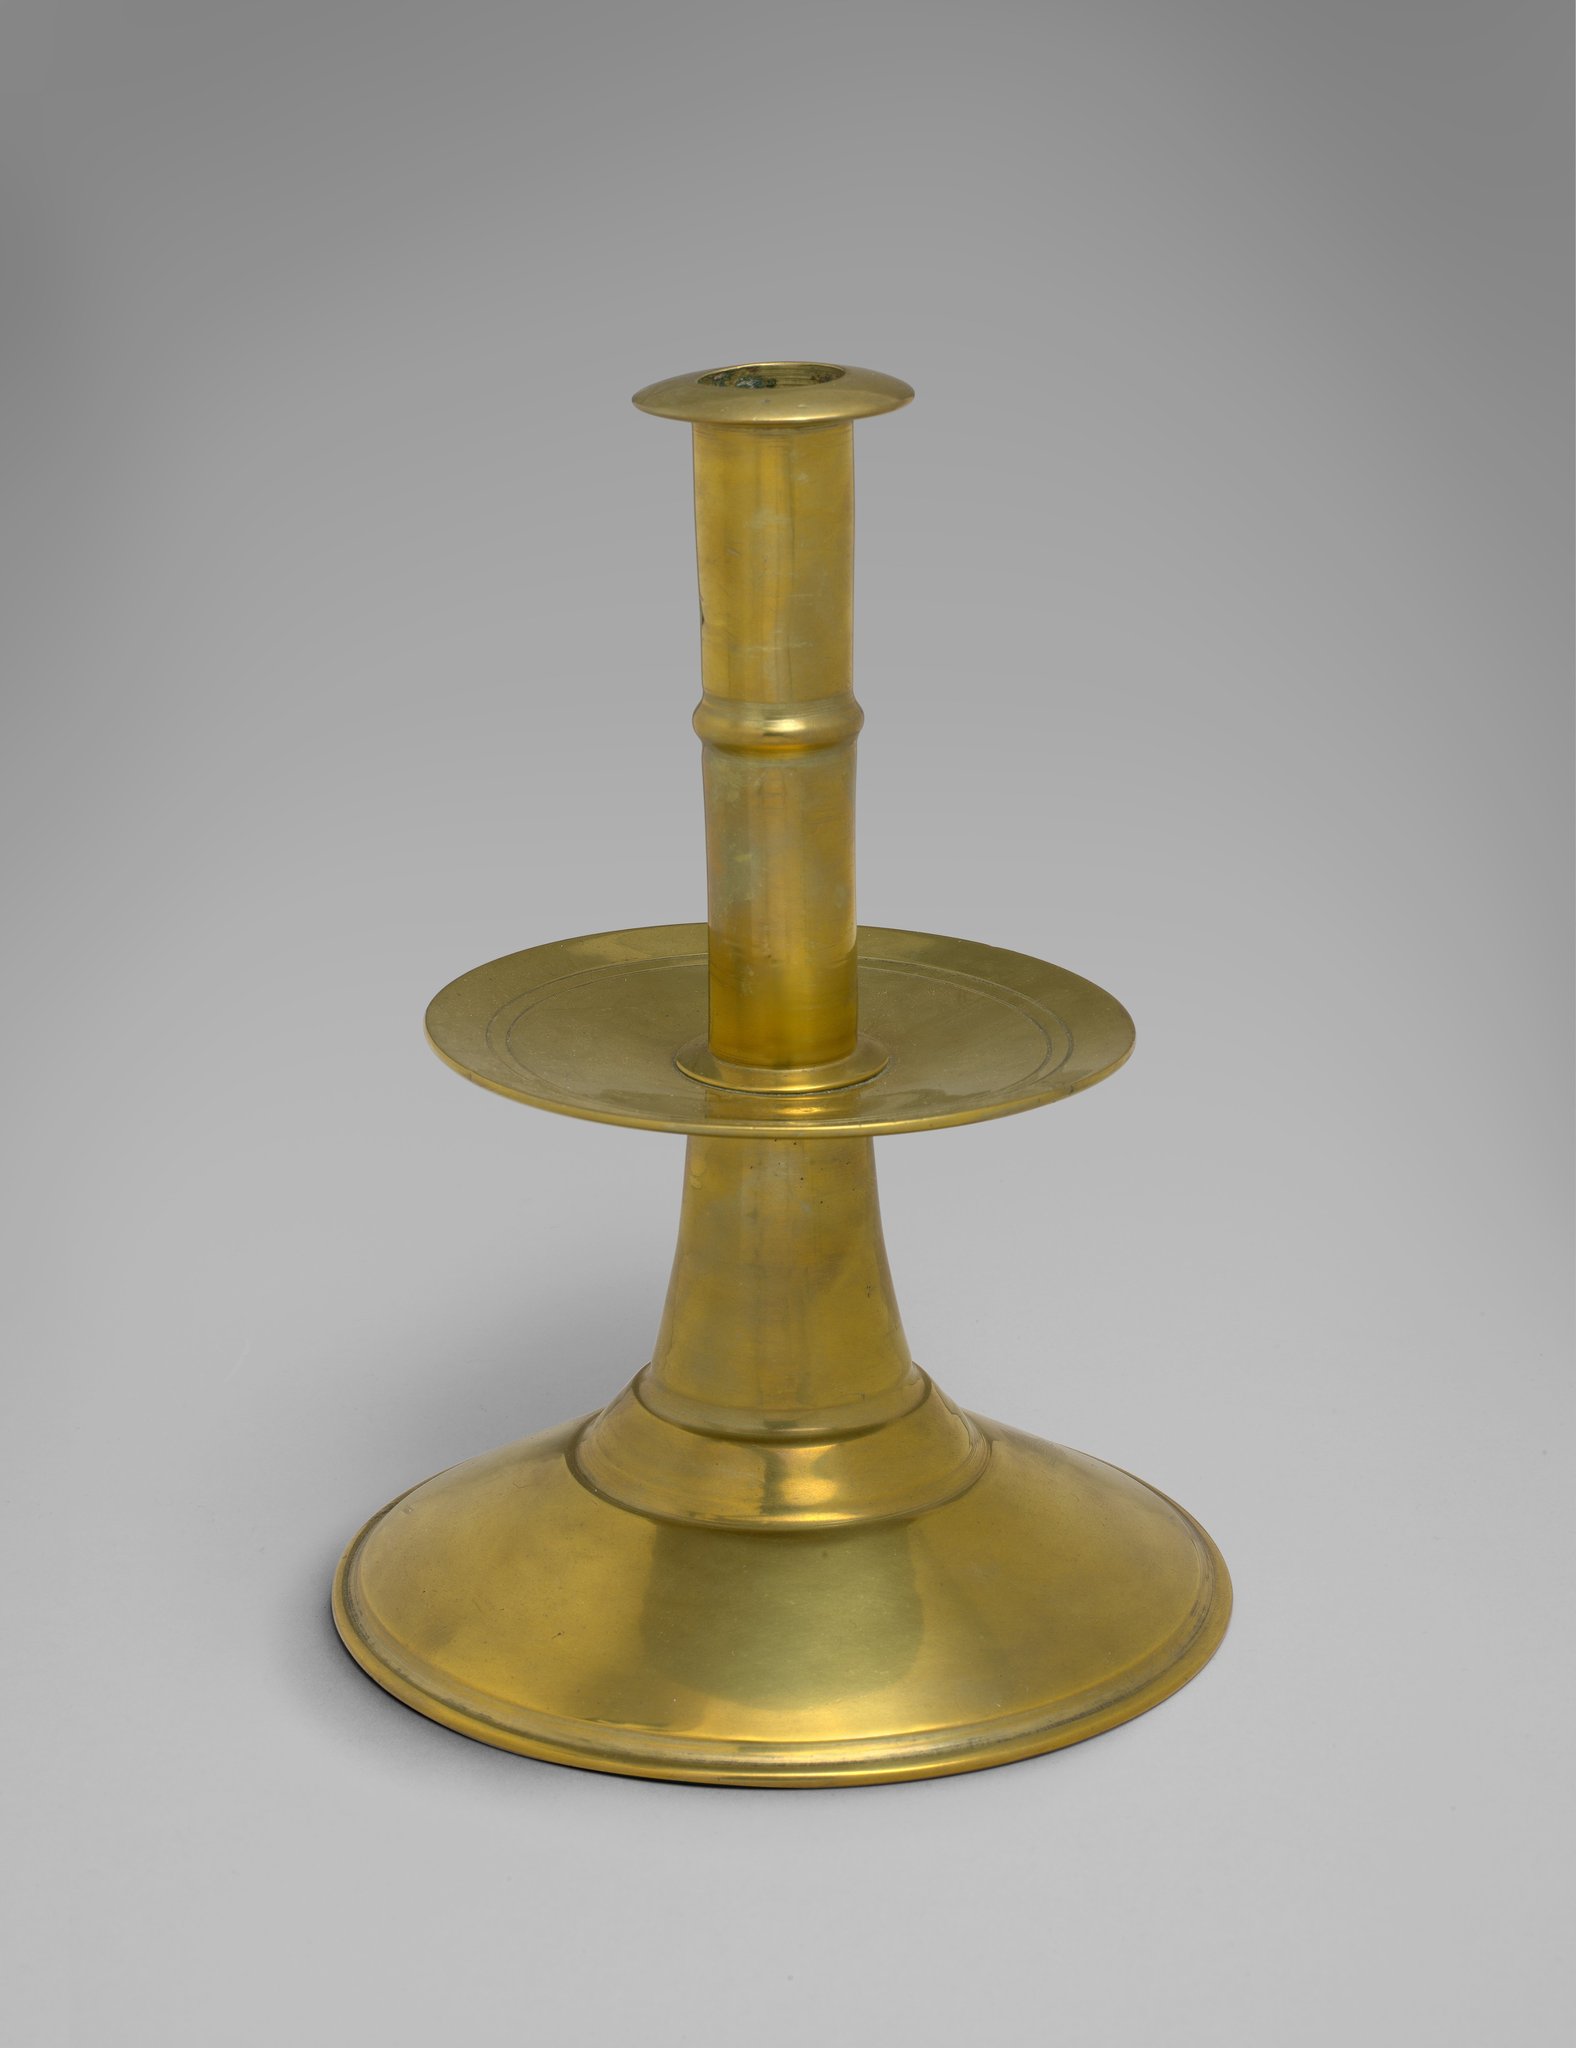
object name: candlestick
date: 1670-1700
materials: brass